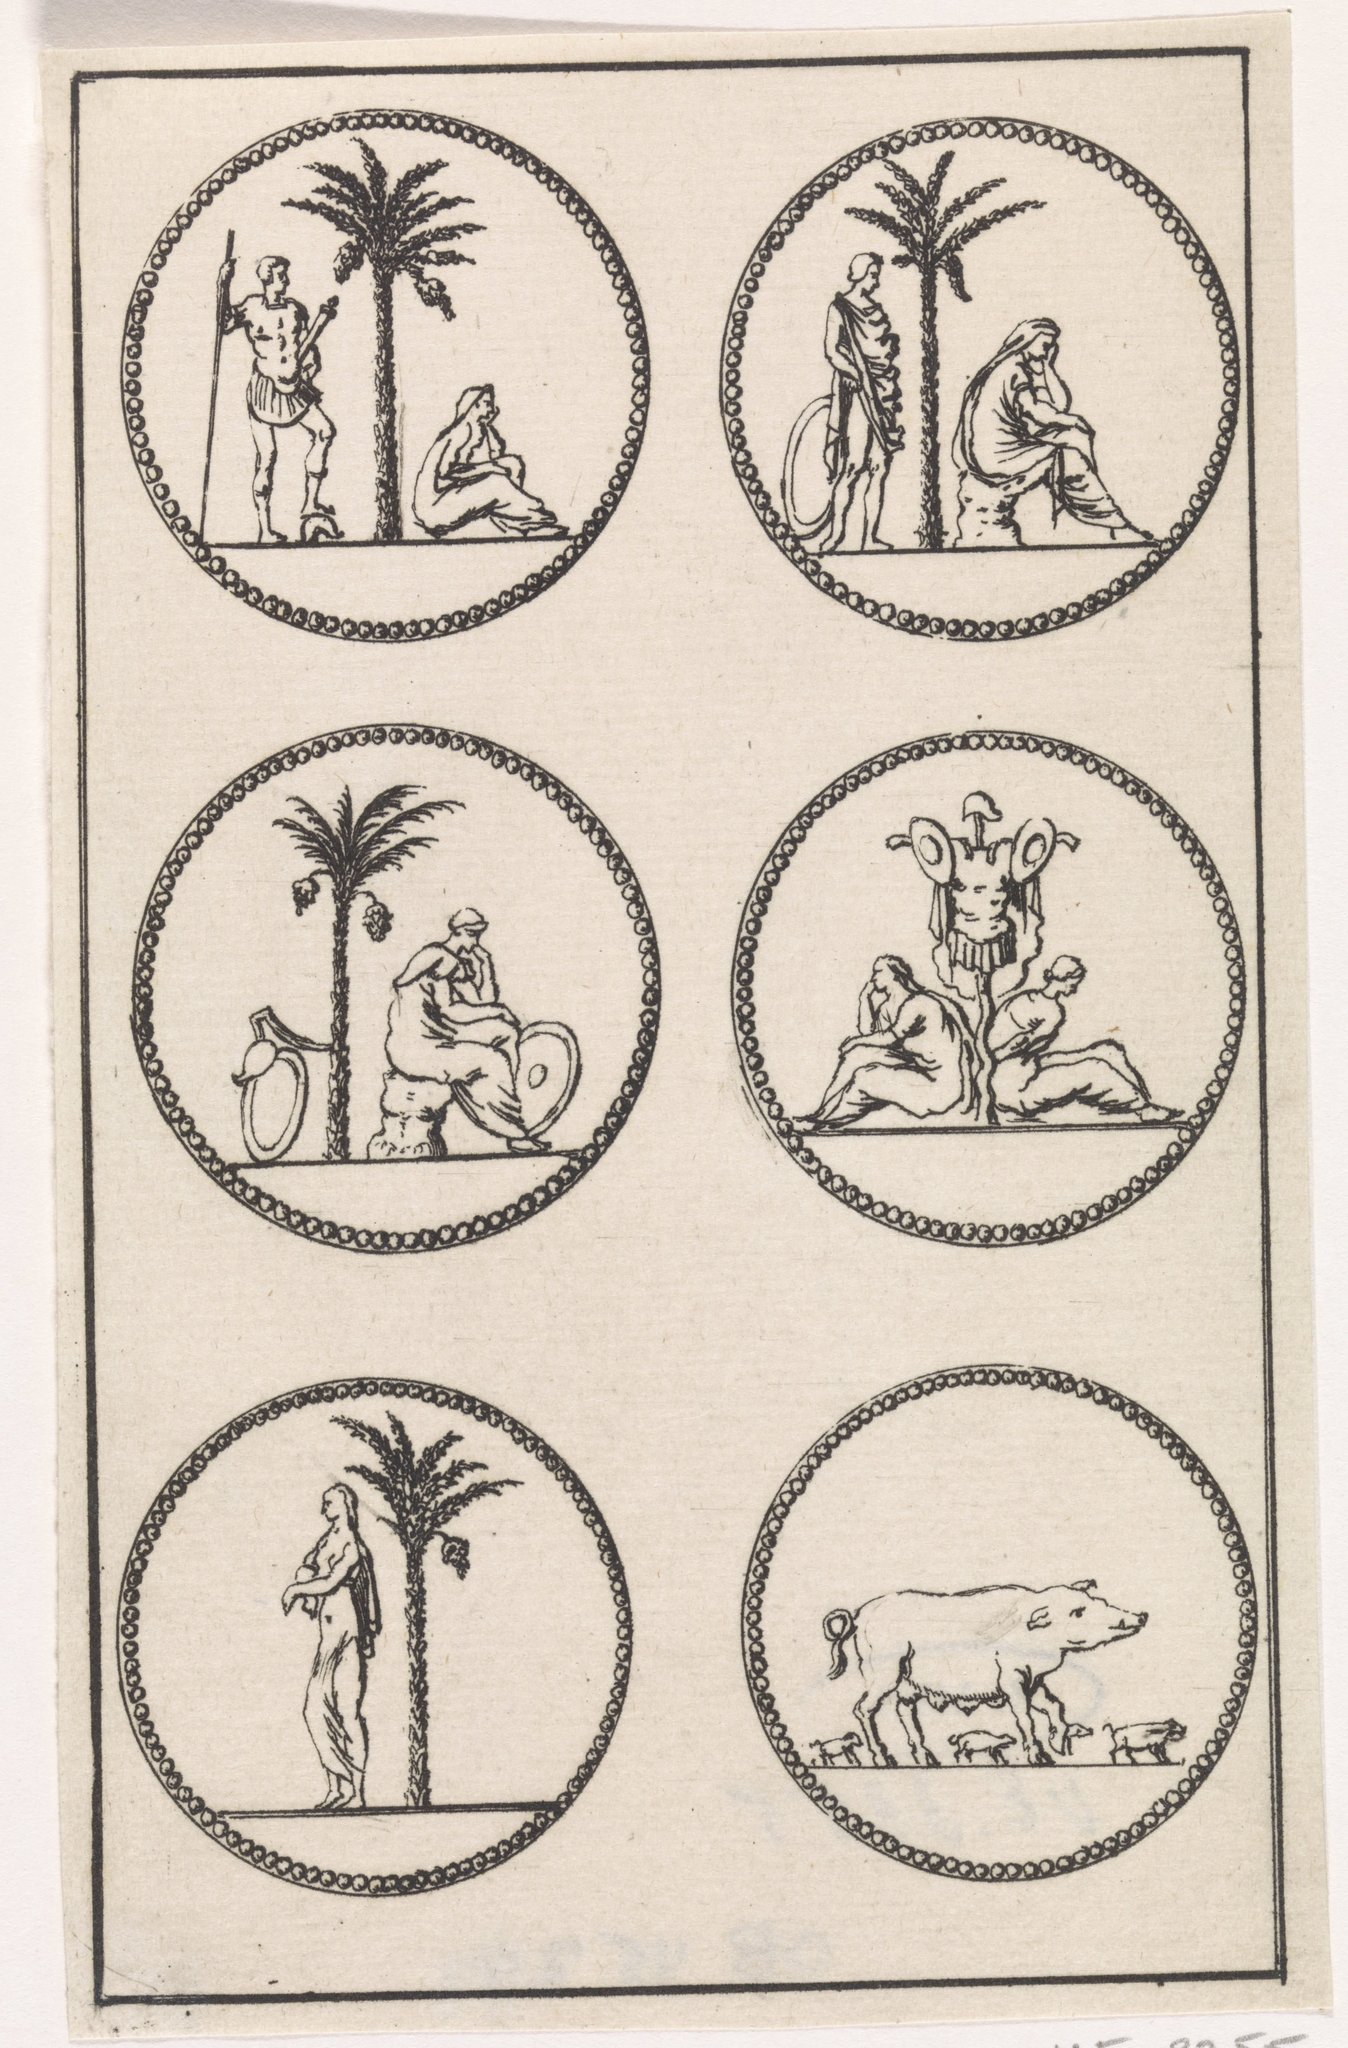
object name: print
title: Zes Romeinse penningen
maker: jan luyken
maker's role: draughtsman, print maker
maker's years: 1649-1712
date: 1705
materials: paper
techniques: etching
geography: amsterdam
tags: medal (considered as a piece of sculpture, regardless of its specific function)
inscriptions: collector's mark: Lugt 2228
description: Proefdruk van illustratie uit: Cunaeus, Petrus. La republique des Hebreux, 3 delen. Amsterdam: Pieter Mortier, 1705, dl. I, p. 203.